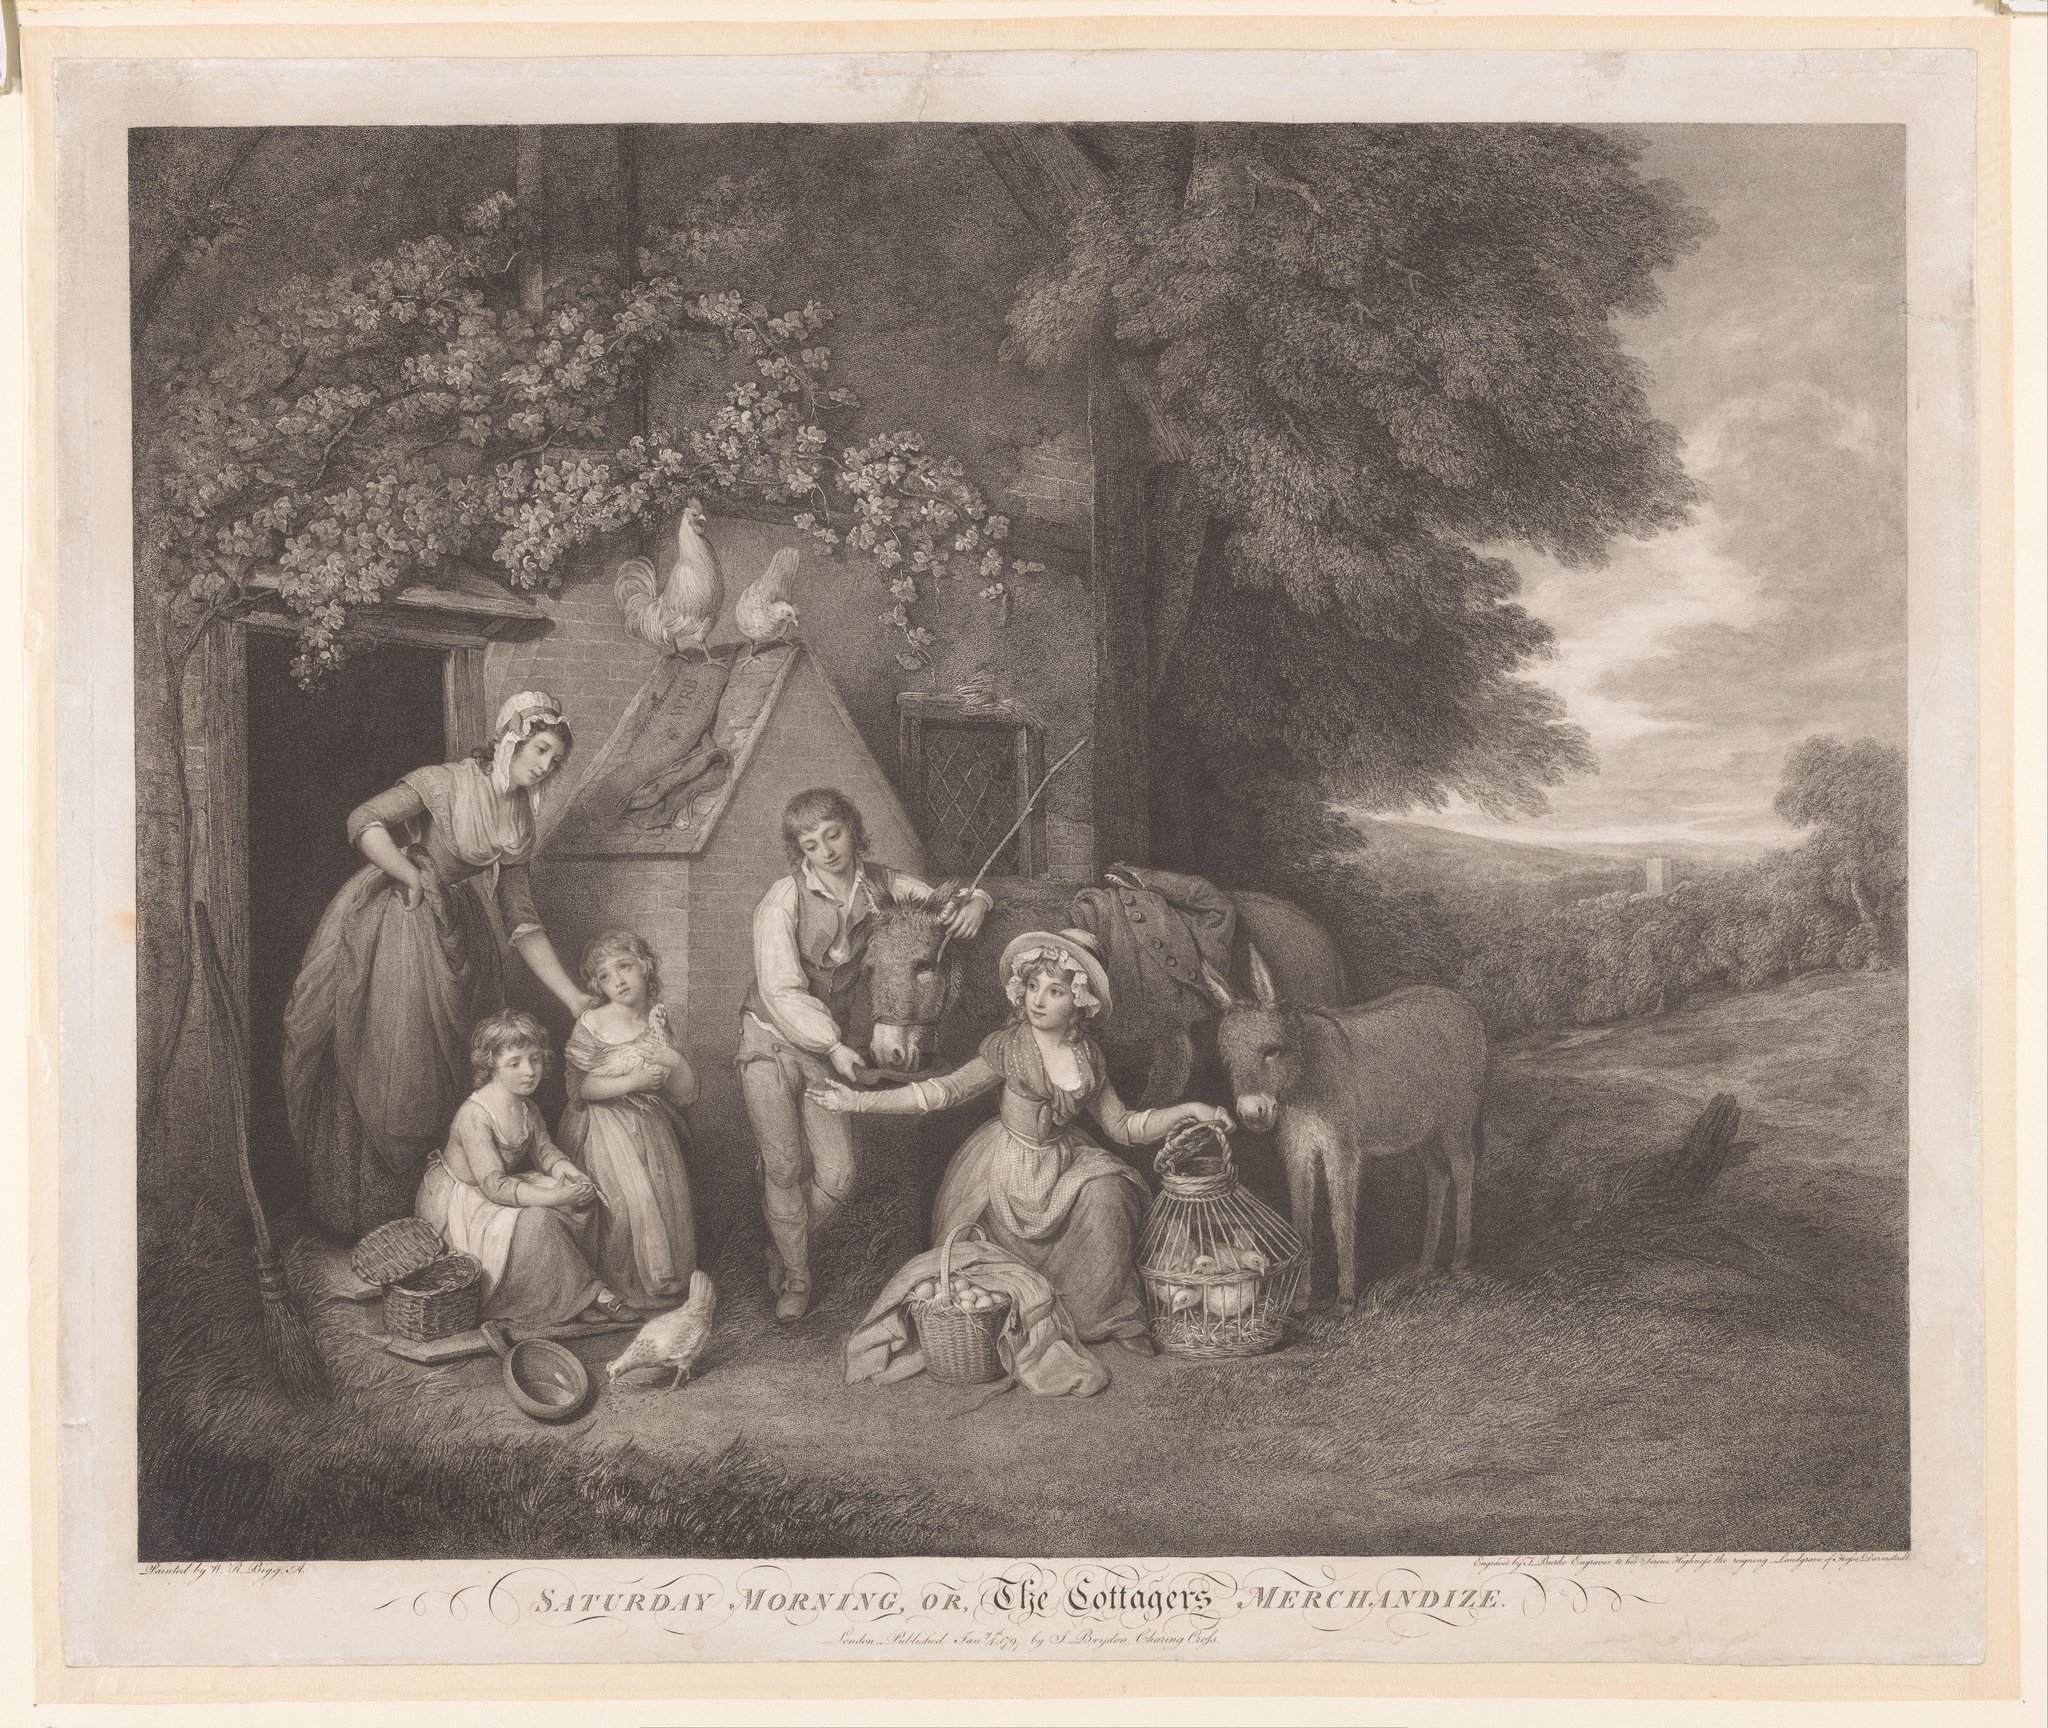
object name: print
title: Jongen met muilezel en meisje met eieren en kippen verkopen hun goederen aan huis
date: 1797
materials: paper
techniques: engraving, etching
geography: london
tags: farmers, family life, selling, farm or solitary house in landscape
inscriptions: date